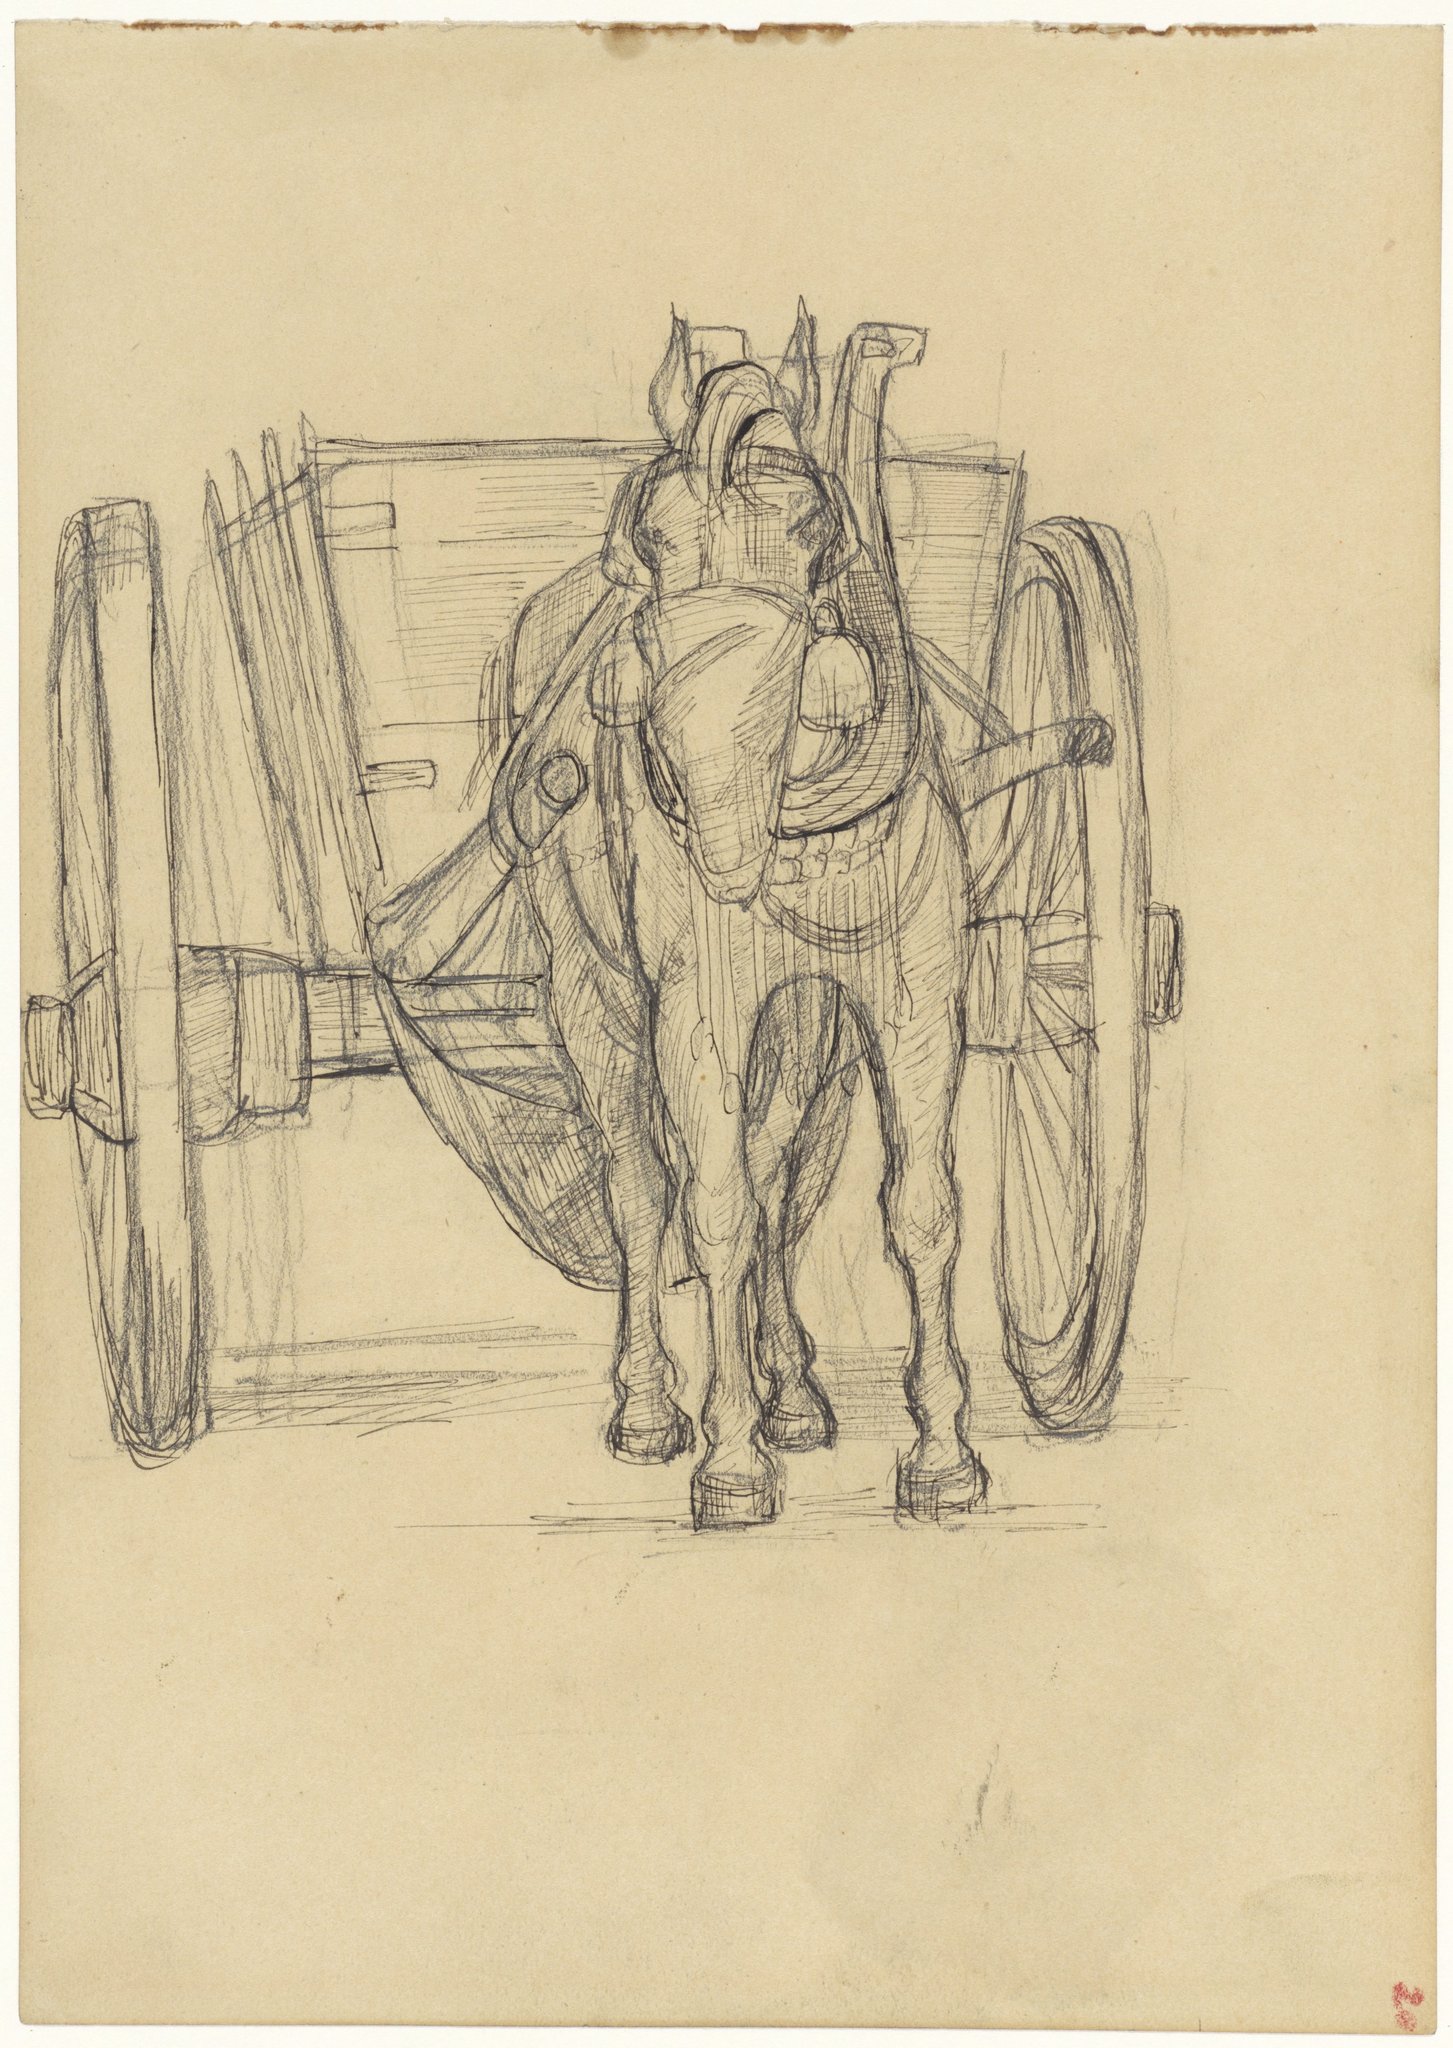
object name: drawing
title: Etend paard voor een kar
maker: jozef israëls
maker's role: draughtsman, painter, print maker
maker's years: 1824-1911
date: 1834-1911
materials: ink, paper, pencil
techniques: pen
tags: (farm) wagon, freight wagon, cart